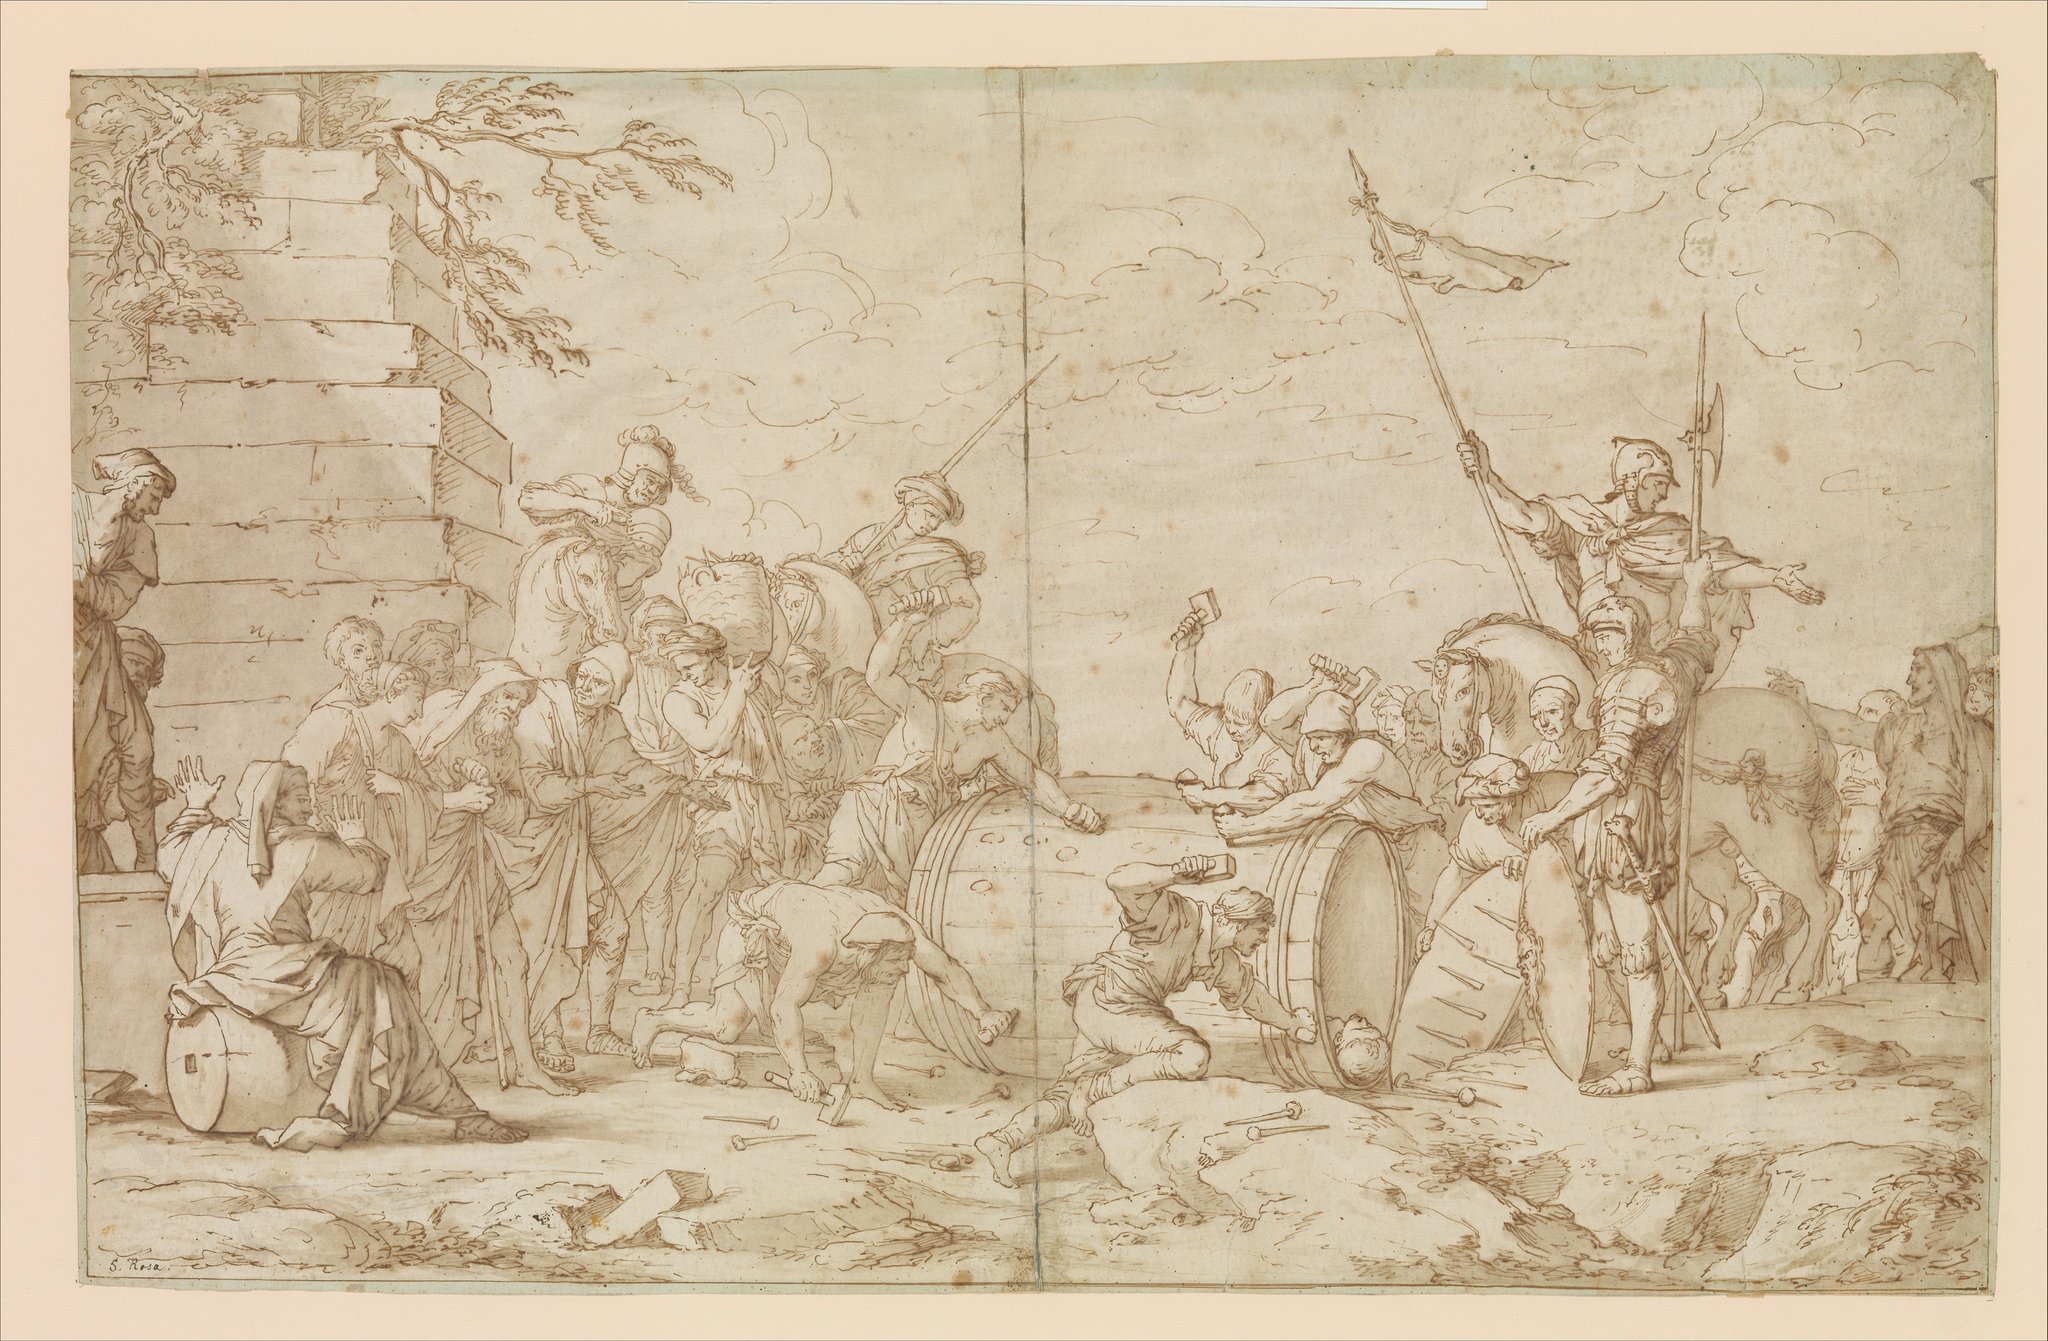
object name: drawing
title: Death of Regulus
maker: salvator rosa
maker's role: artist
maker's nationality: italian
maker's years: 1615-1673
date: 1615-1673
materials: ink, paper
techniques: brush, pen, wash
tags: weapons,swords,men,horses,death